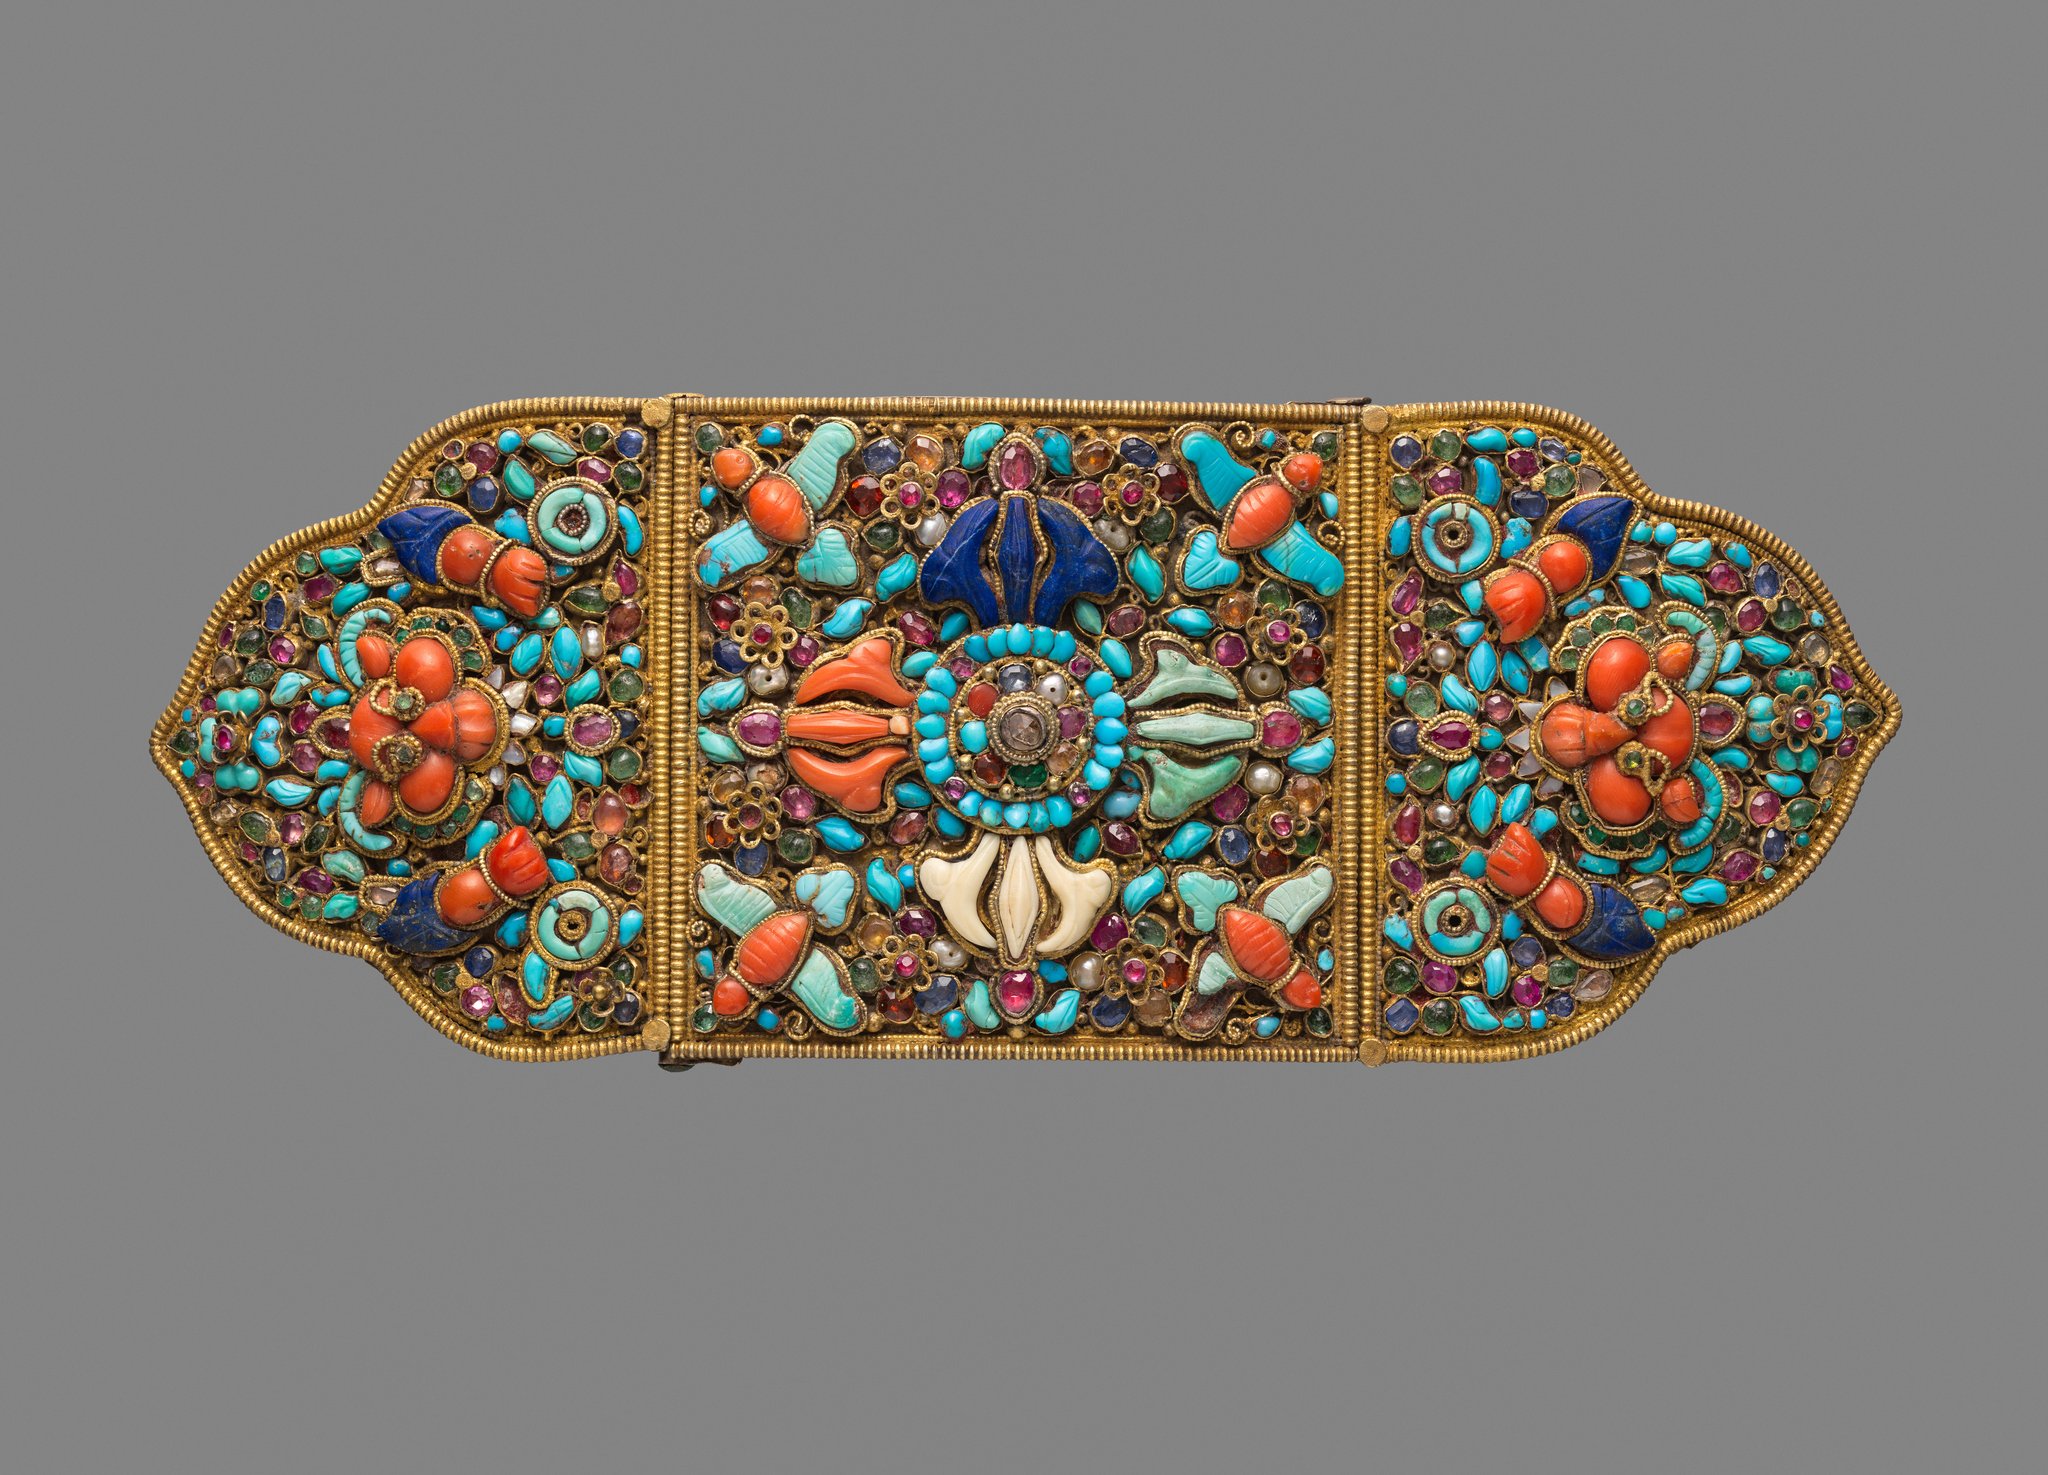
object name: ornament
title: Armlet for an Image with Crossed Vajras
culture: nepali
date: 1601-1900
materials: amber, coral, diamond, gemstone, silver gilt, lapis lazuli, mercury, mother of pearl, pearl, shell